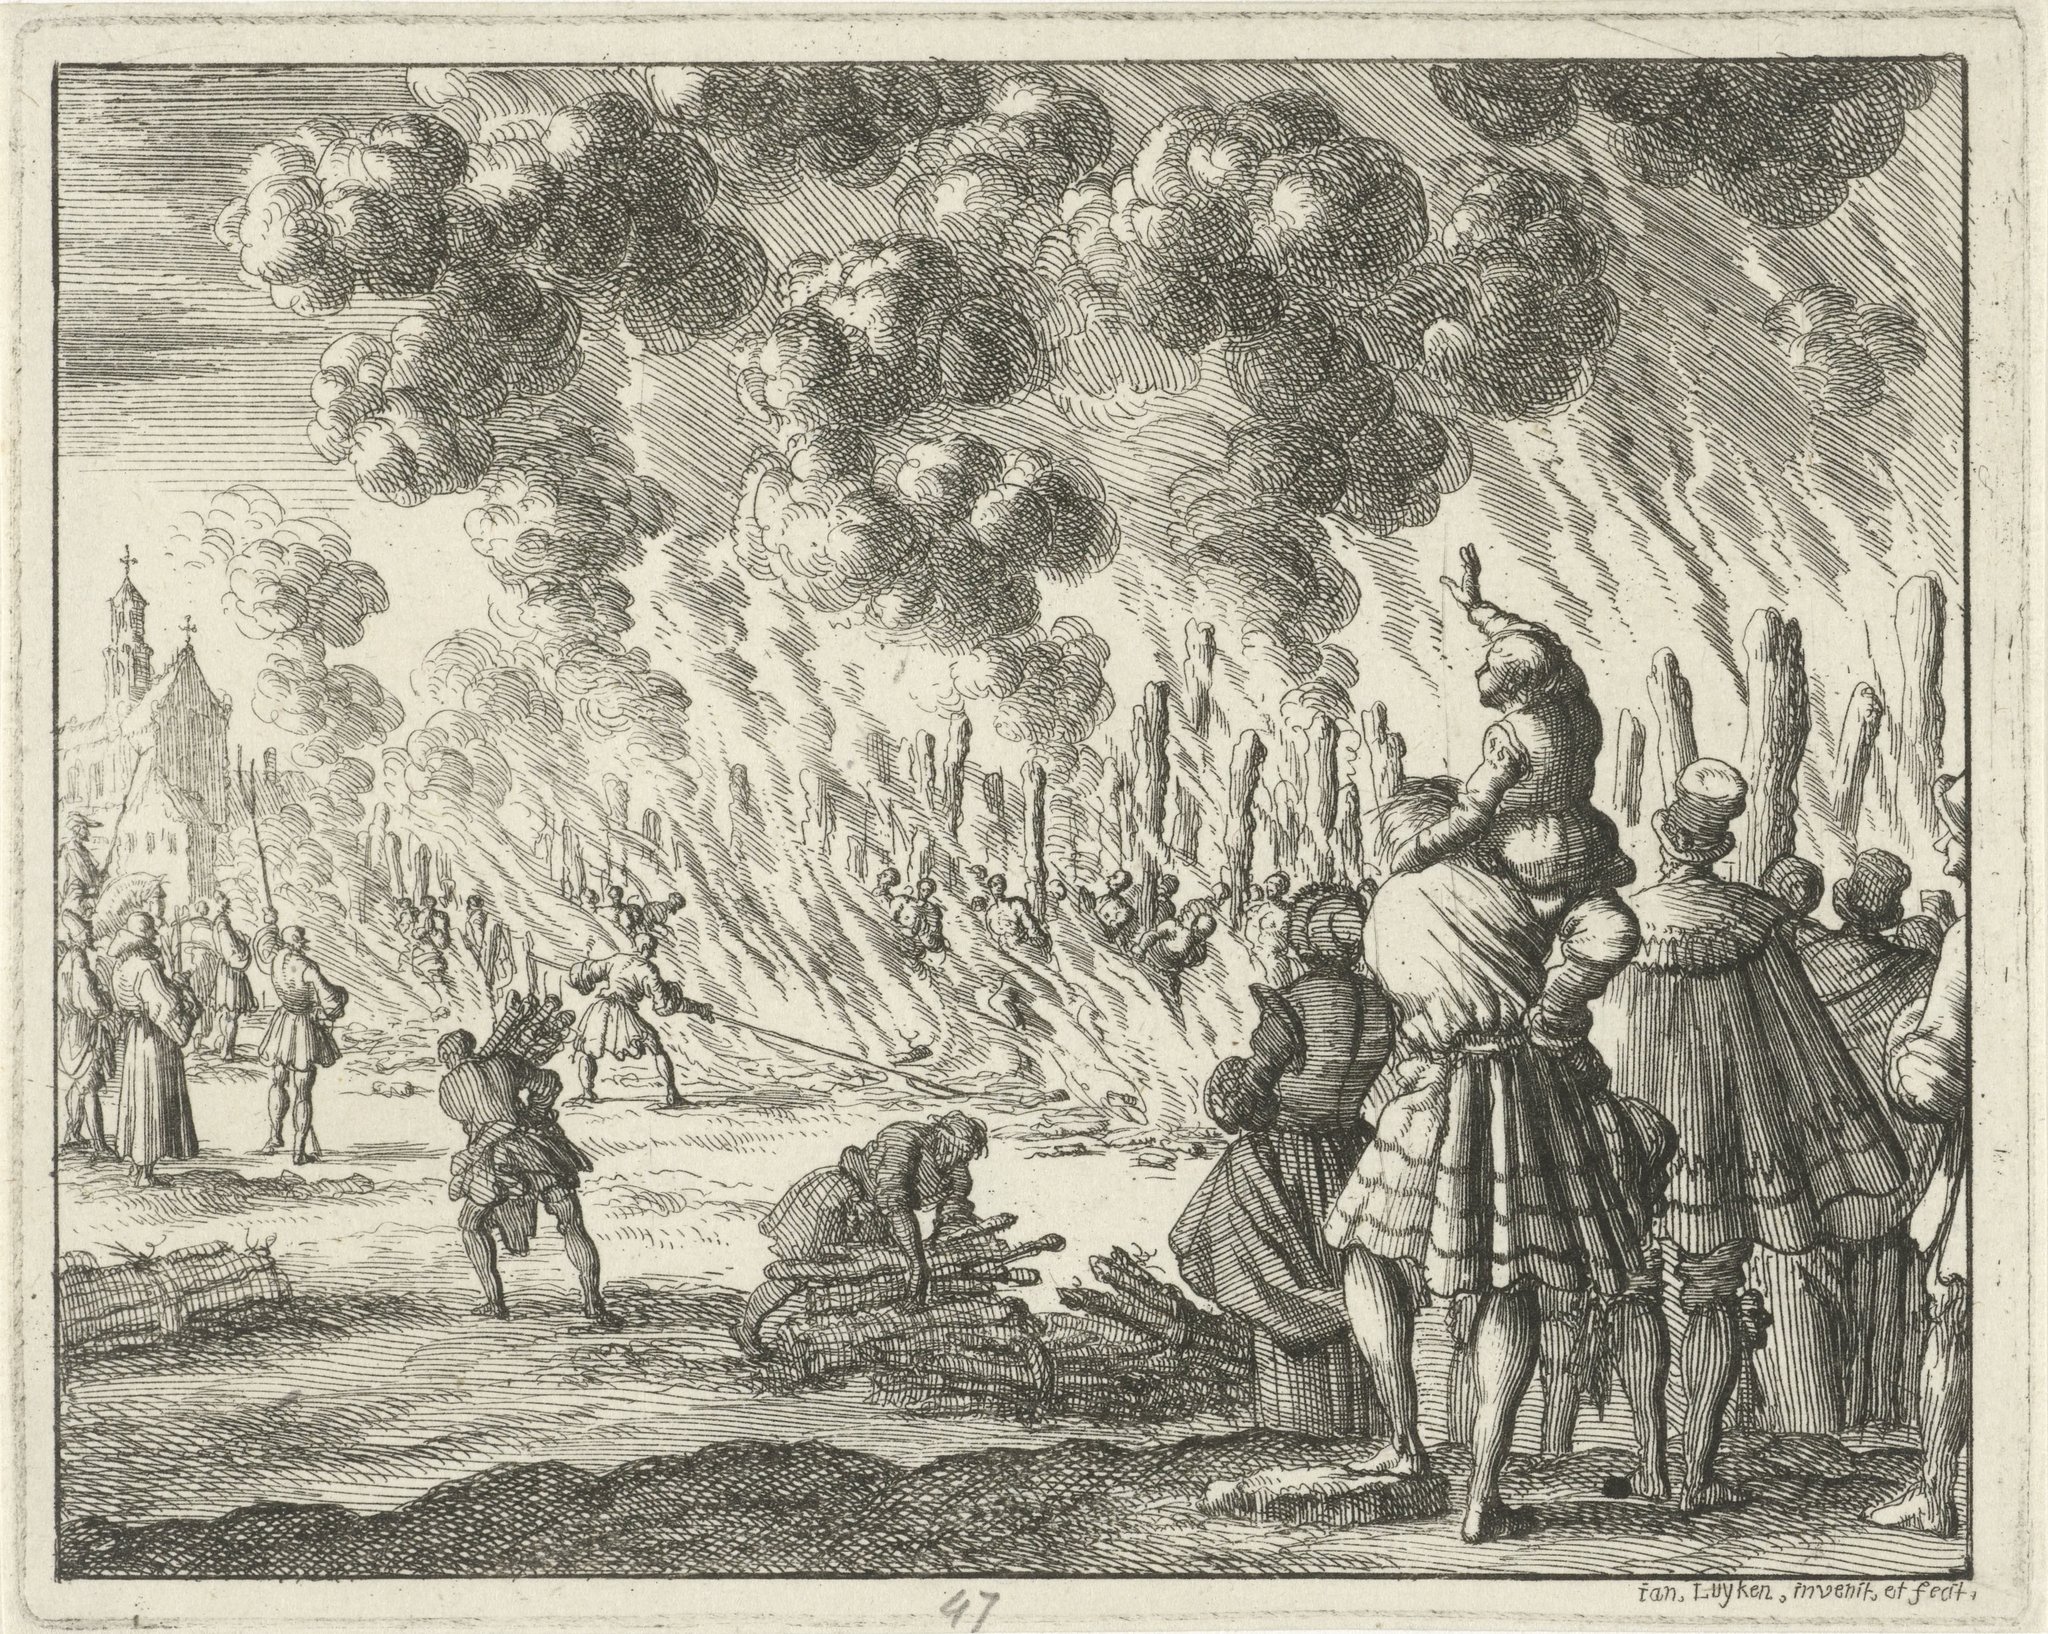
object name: book illustration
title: 224 Waldenzen bij Toulouse verbrand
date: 1685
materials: paper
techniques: etching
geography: amsterdam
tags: violent death by burning at the stake; pyre, persecution of heretics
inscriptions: collector's mark: Lugt 2228, number: ‘47’